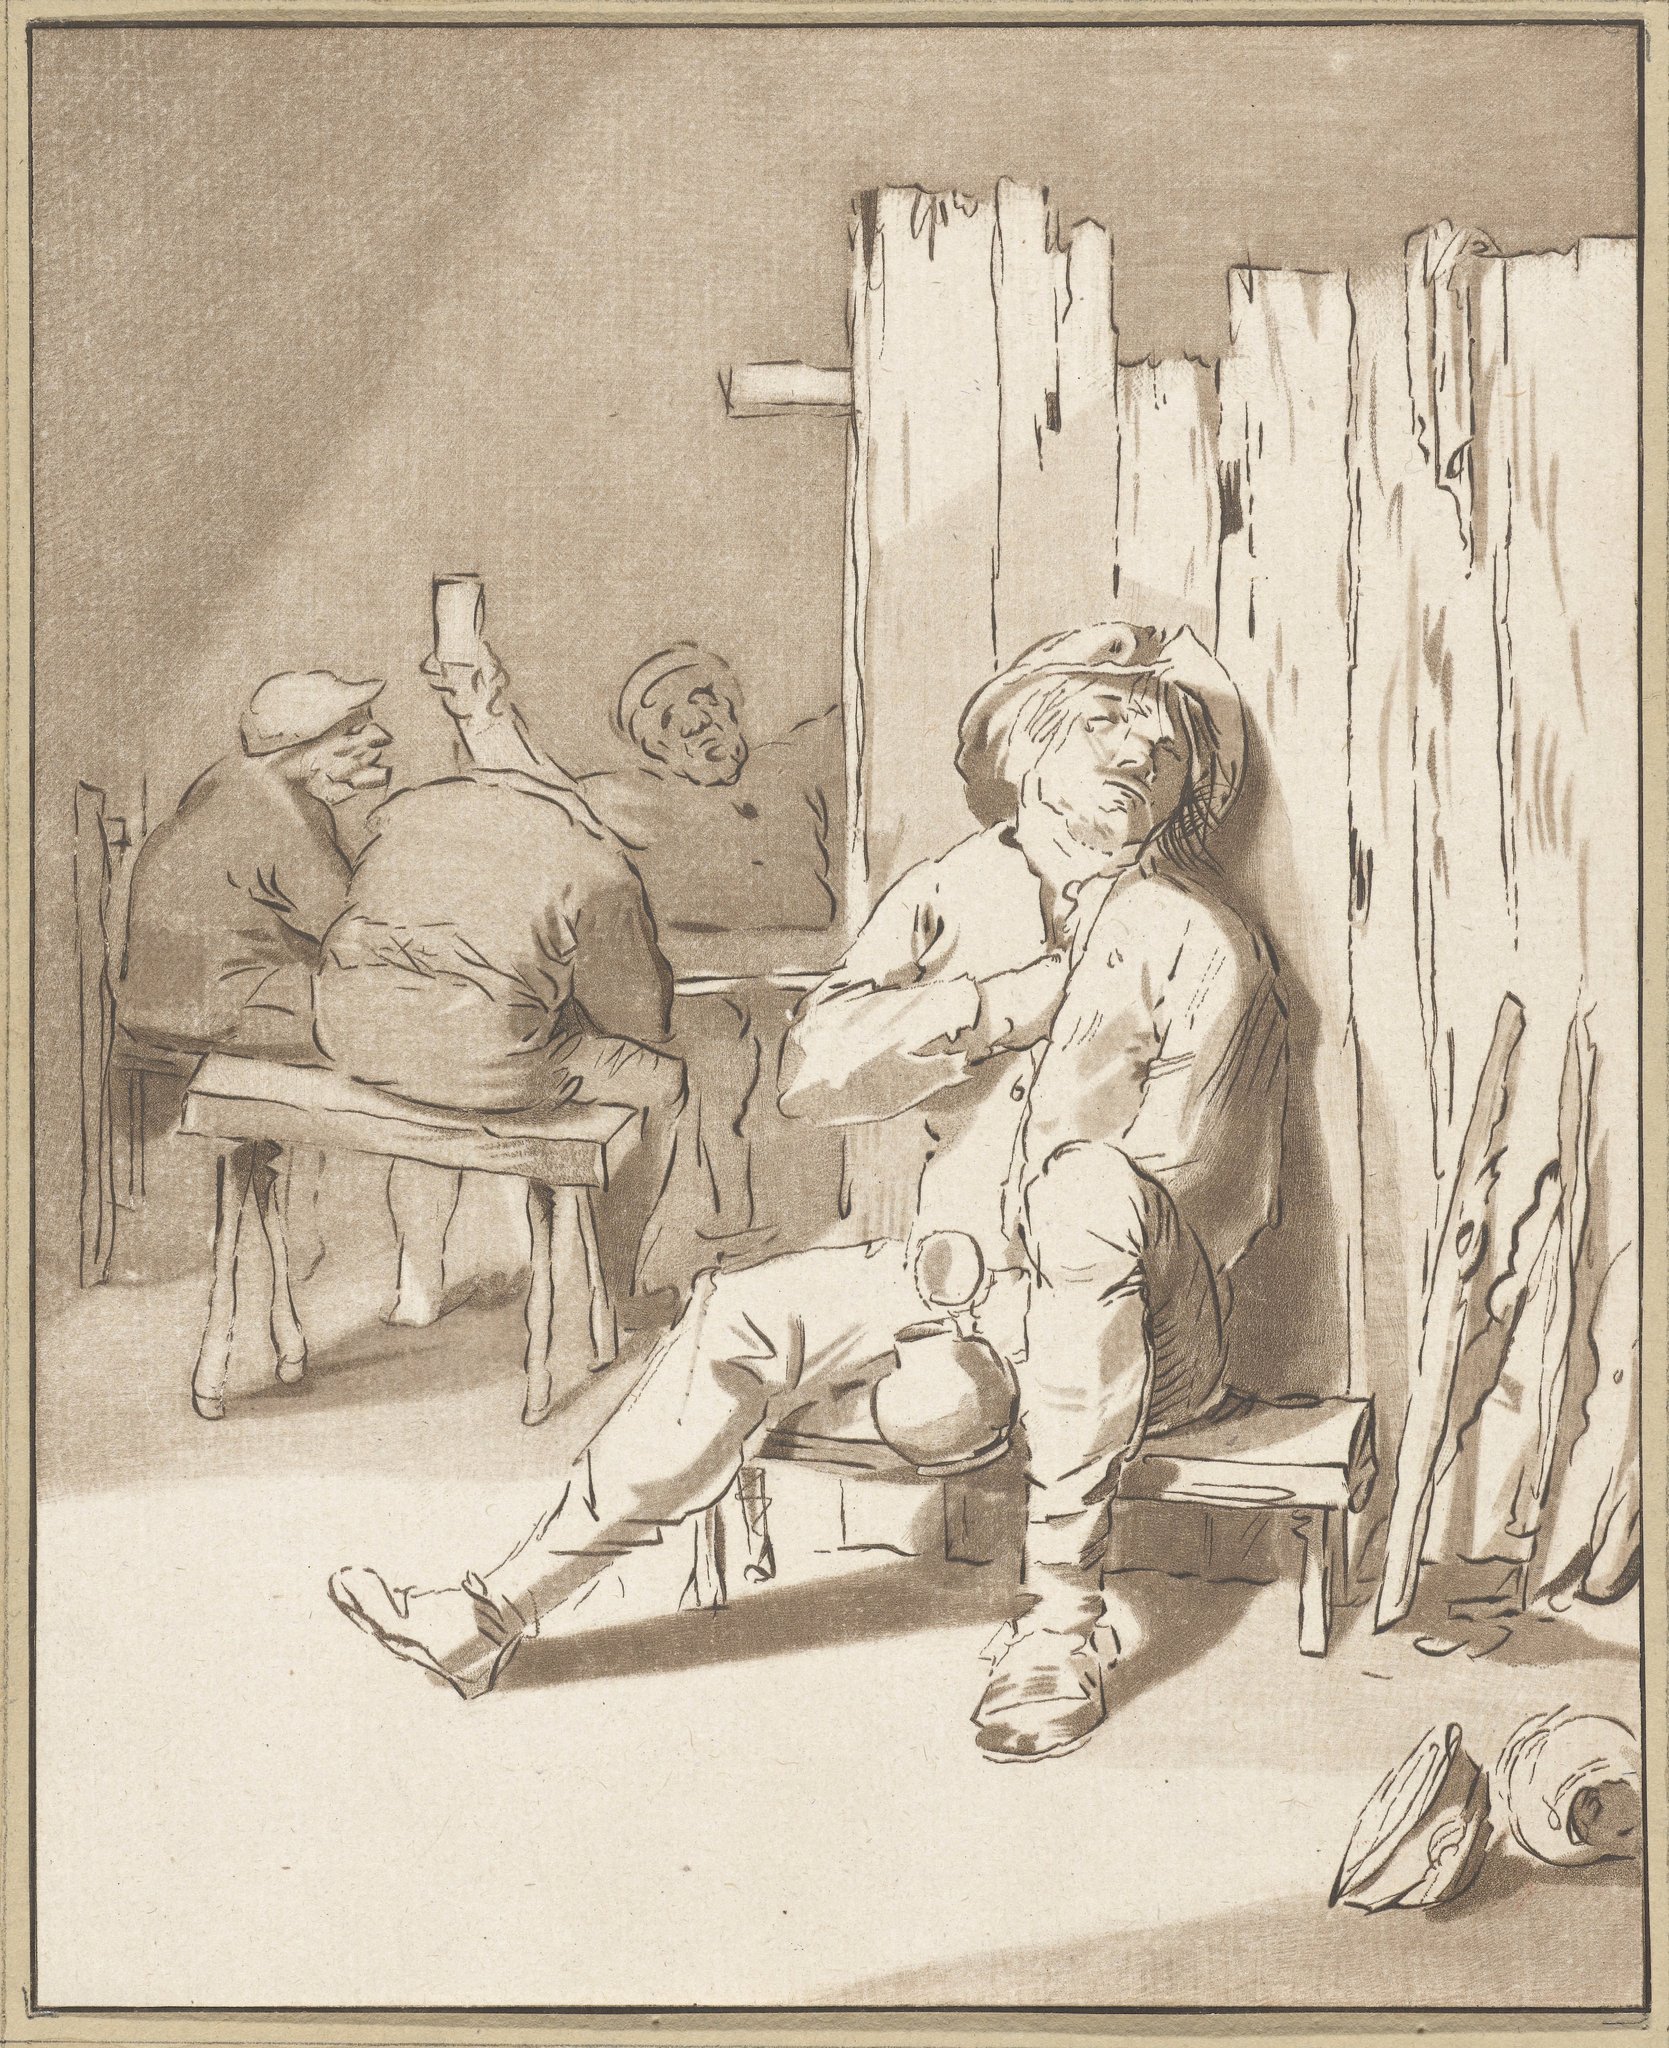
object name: print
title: Dronken boer in herberg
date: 1775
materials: paper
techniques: etching, roulette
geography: amsterdam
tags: inn, coffee-house, public house, etc., jar, jug (used as drinking-vessel)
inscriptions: collector's mark: Lugt 2725, collector's mark: Lugt 12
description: Een boer zit op een lage bank in een herberg, met een kruik in zijn hand.